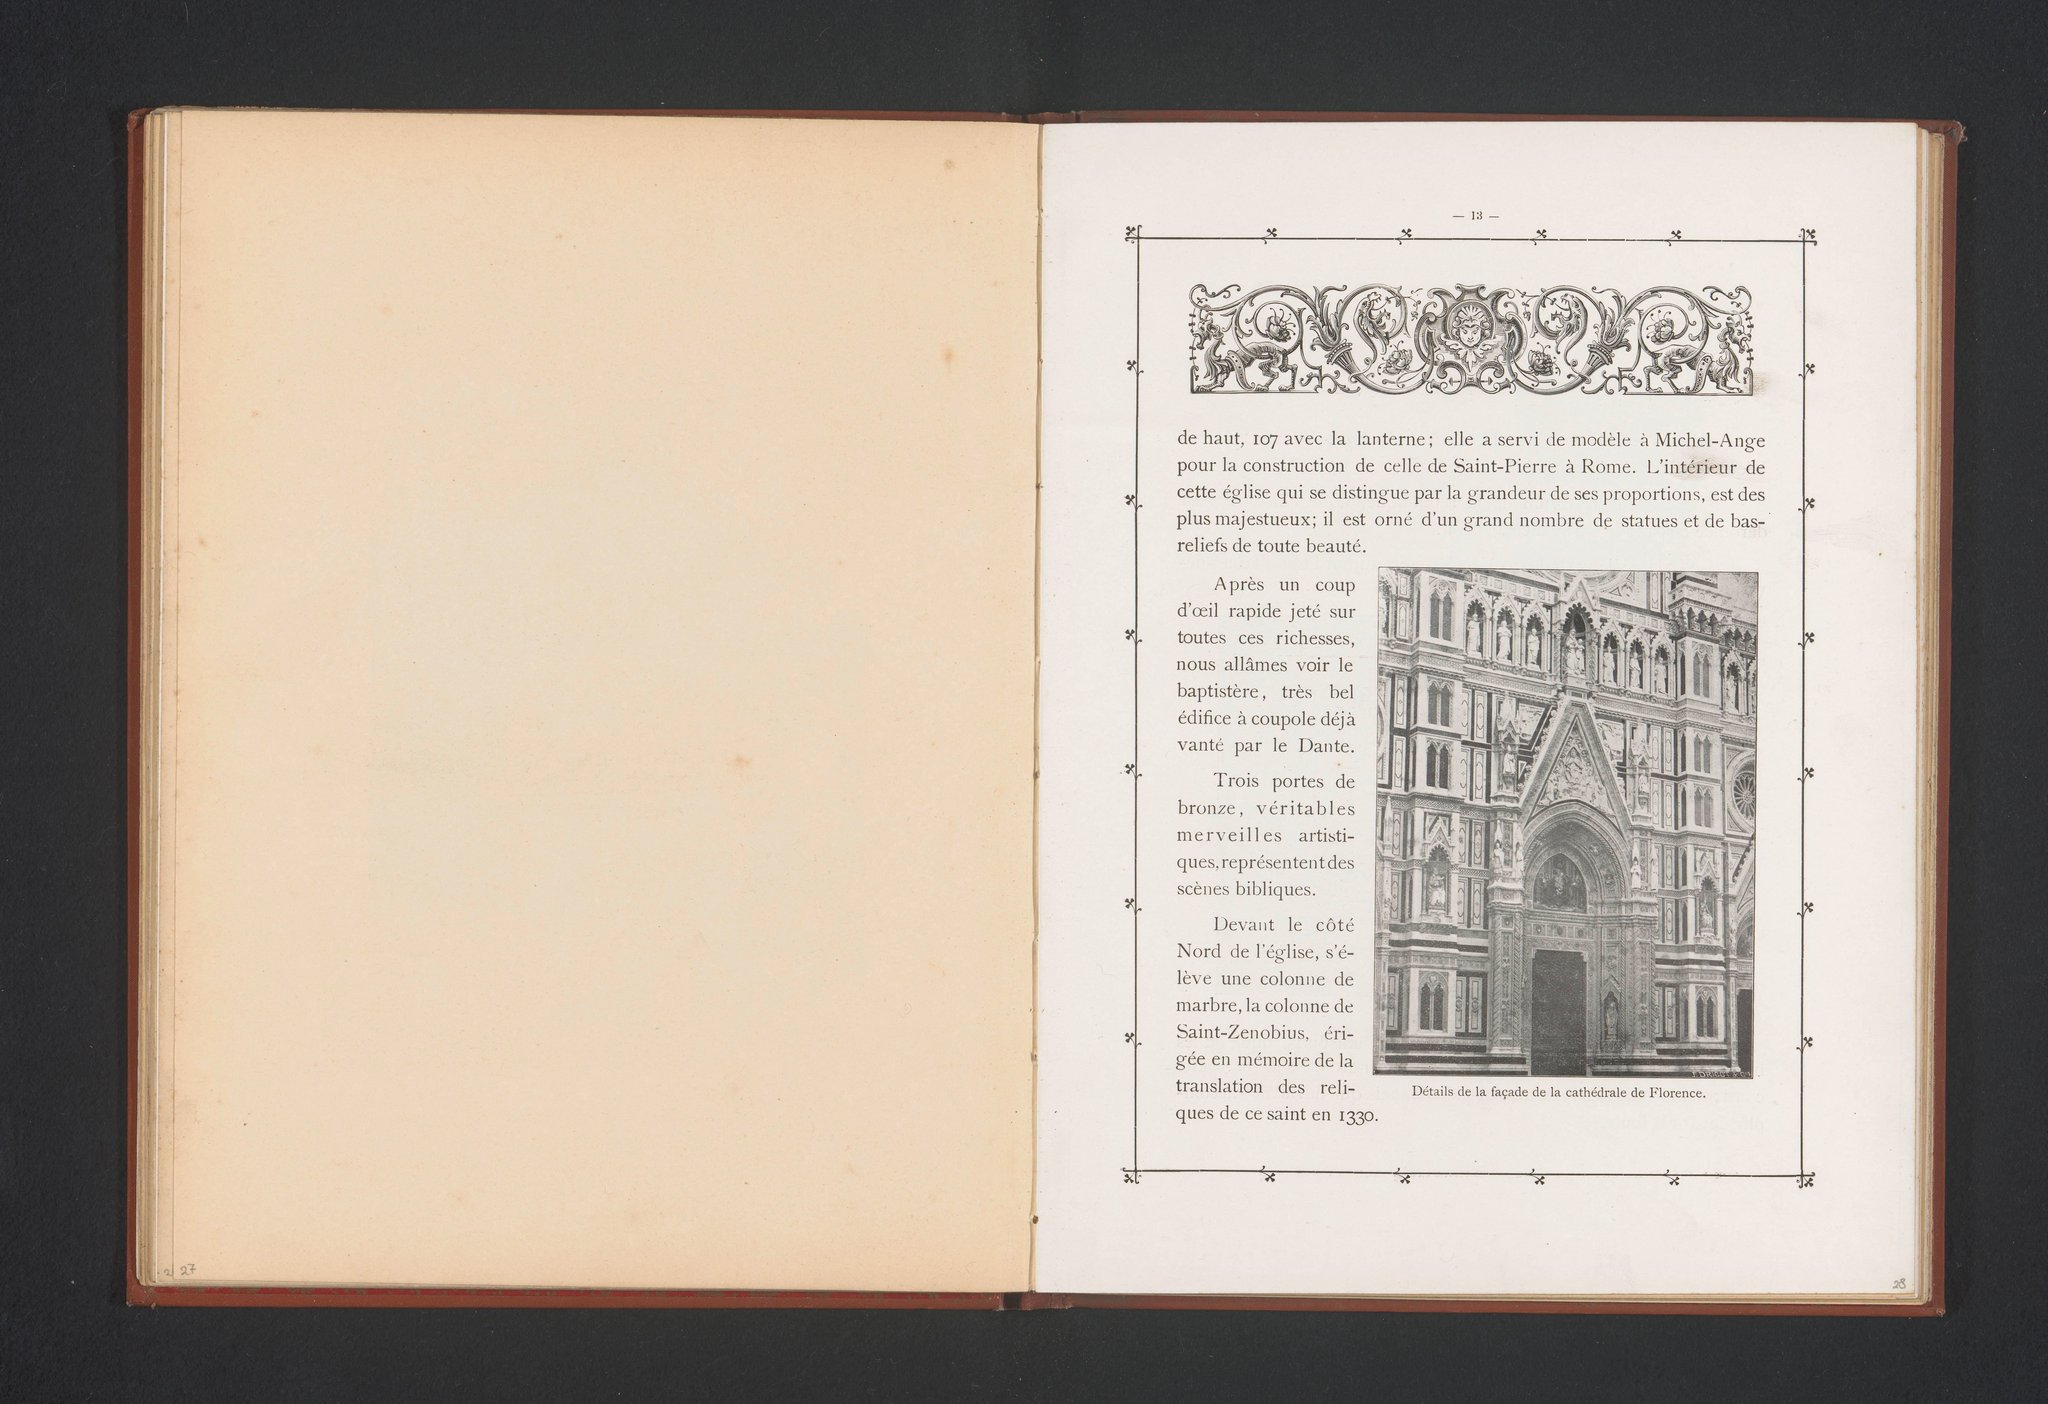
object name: page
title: Détails de la façade de la cathédrale de Florence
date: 1893-1898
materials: paper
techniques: autotype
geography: florence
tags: parts of church exterior and annexes